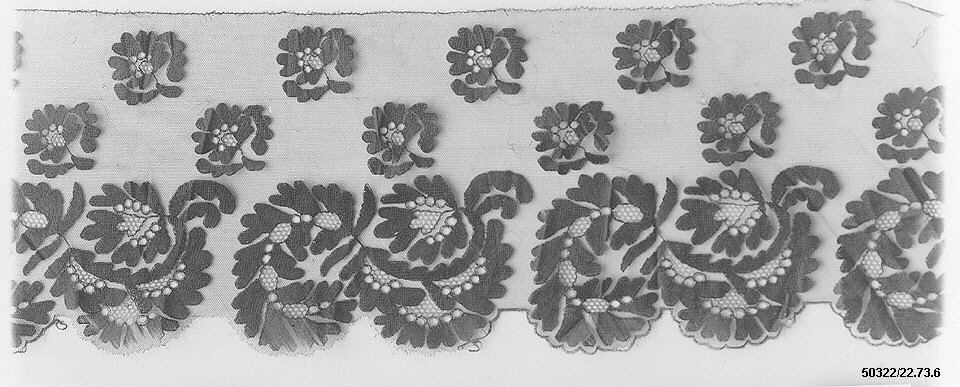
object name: strip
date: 1801-1900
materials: silk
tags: flowers